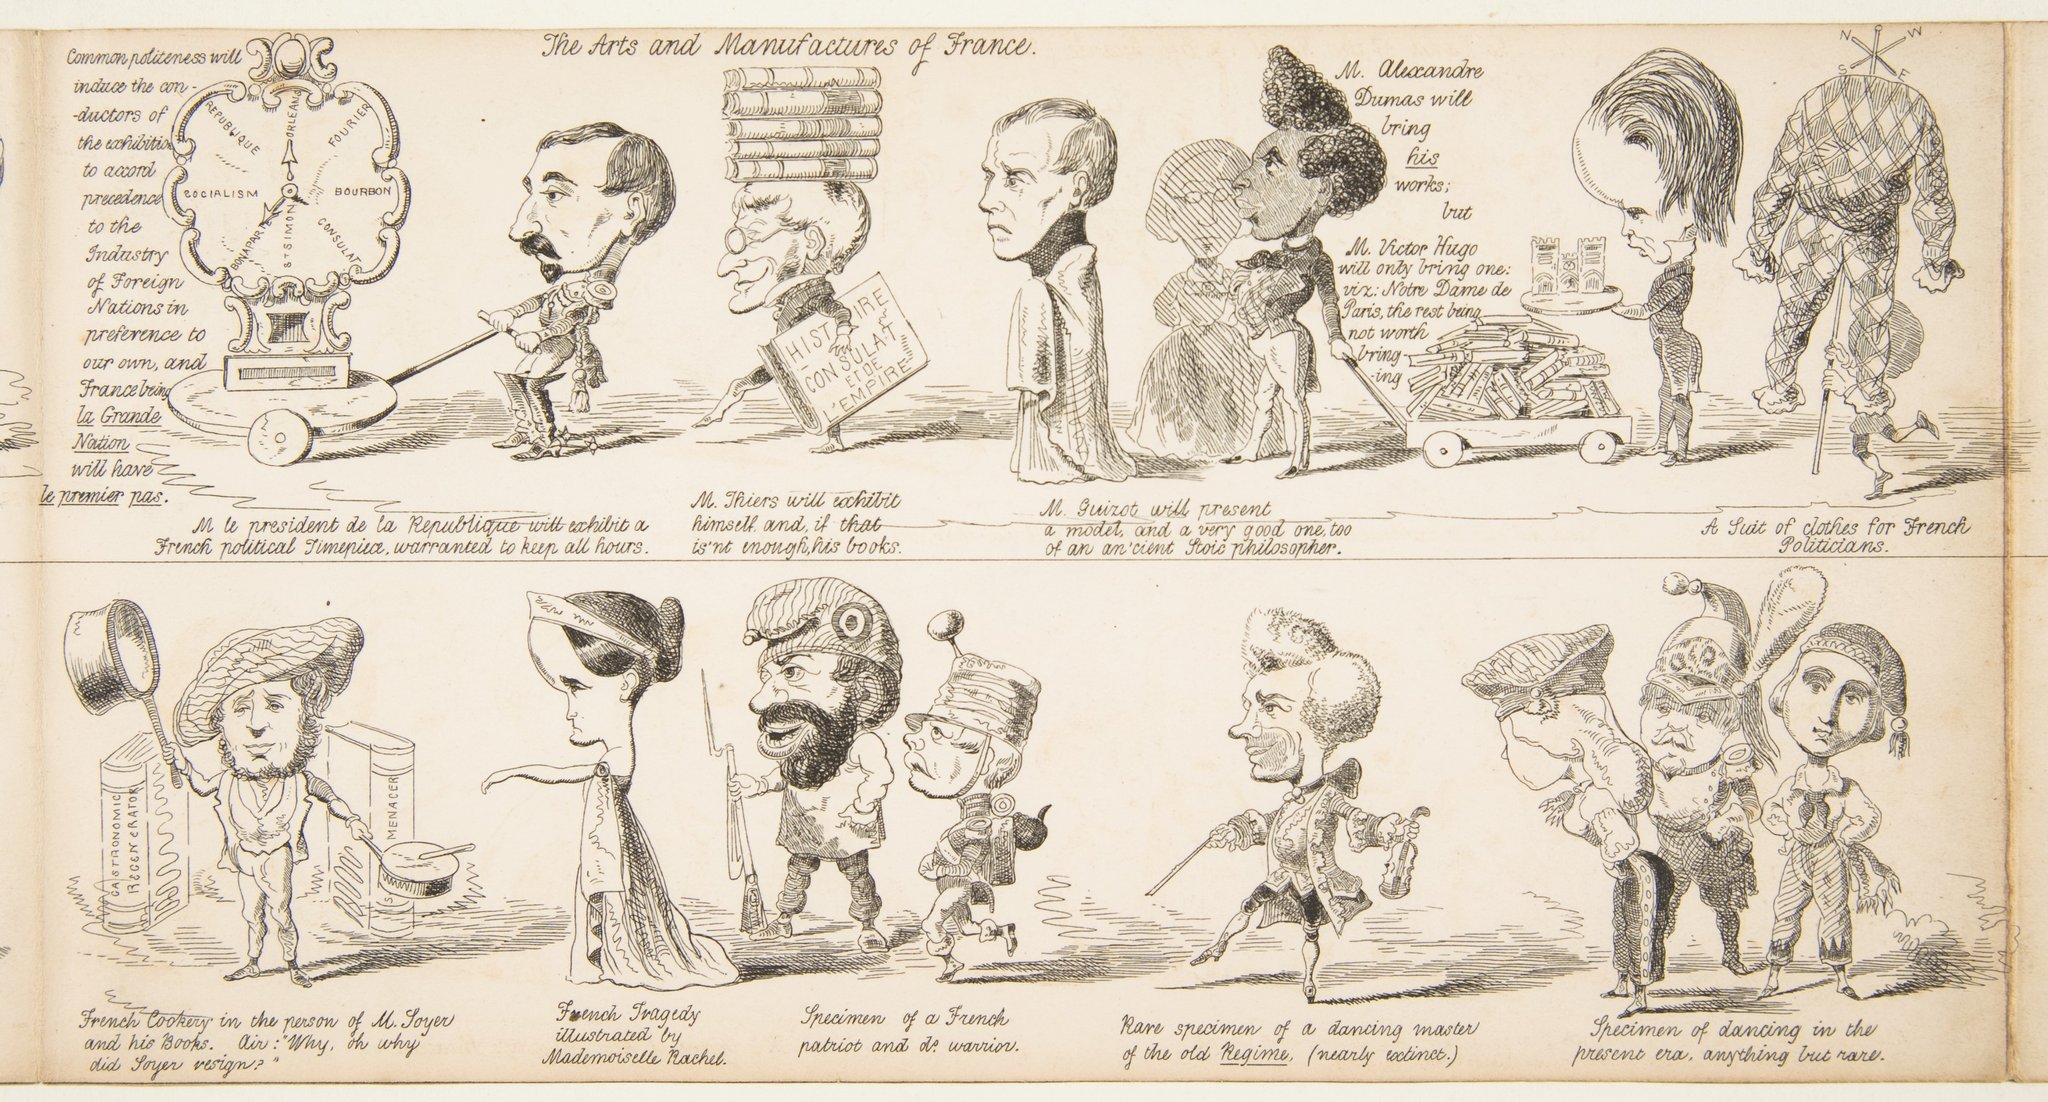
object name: print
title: The Great Exhibition "Wot is to Be", Probable Results of The Industry of All Nations in The Year '51, Showing What is to be Exhibited, Who is To Exhibit, in Short How Its All Going to Be Done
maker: george augustus sala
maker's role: author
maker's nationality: british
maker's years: 1828-1895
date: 1850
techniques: engraving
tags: satire